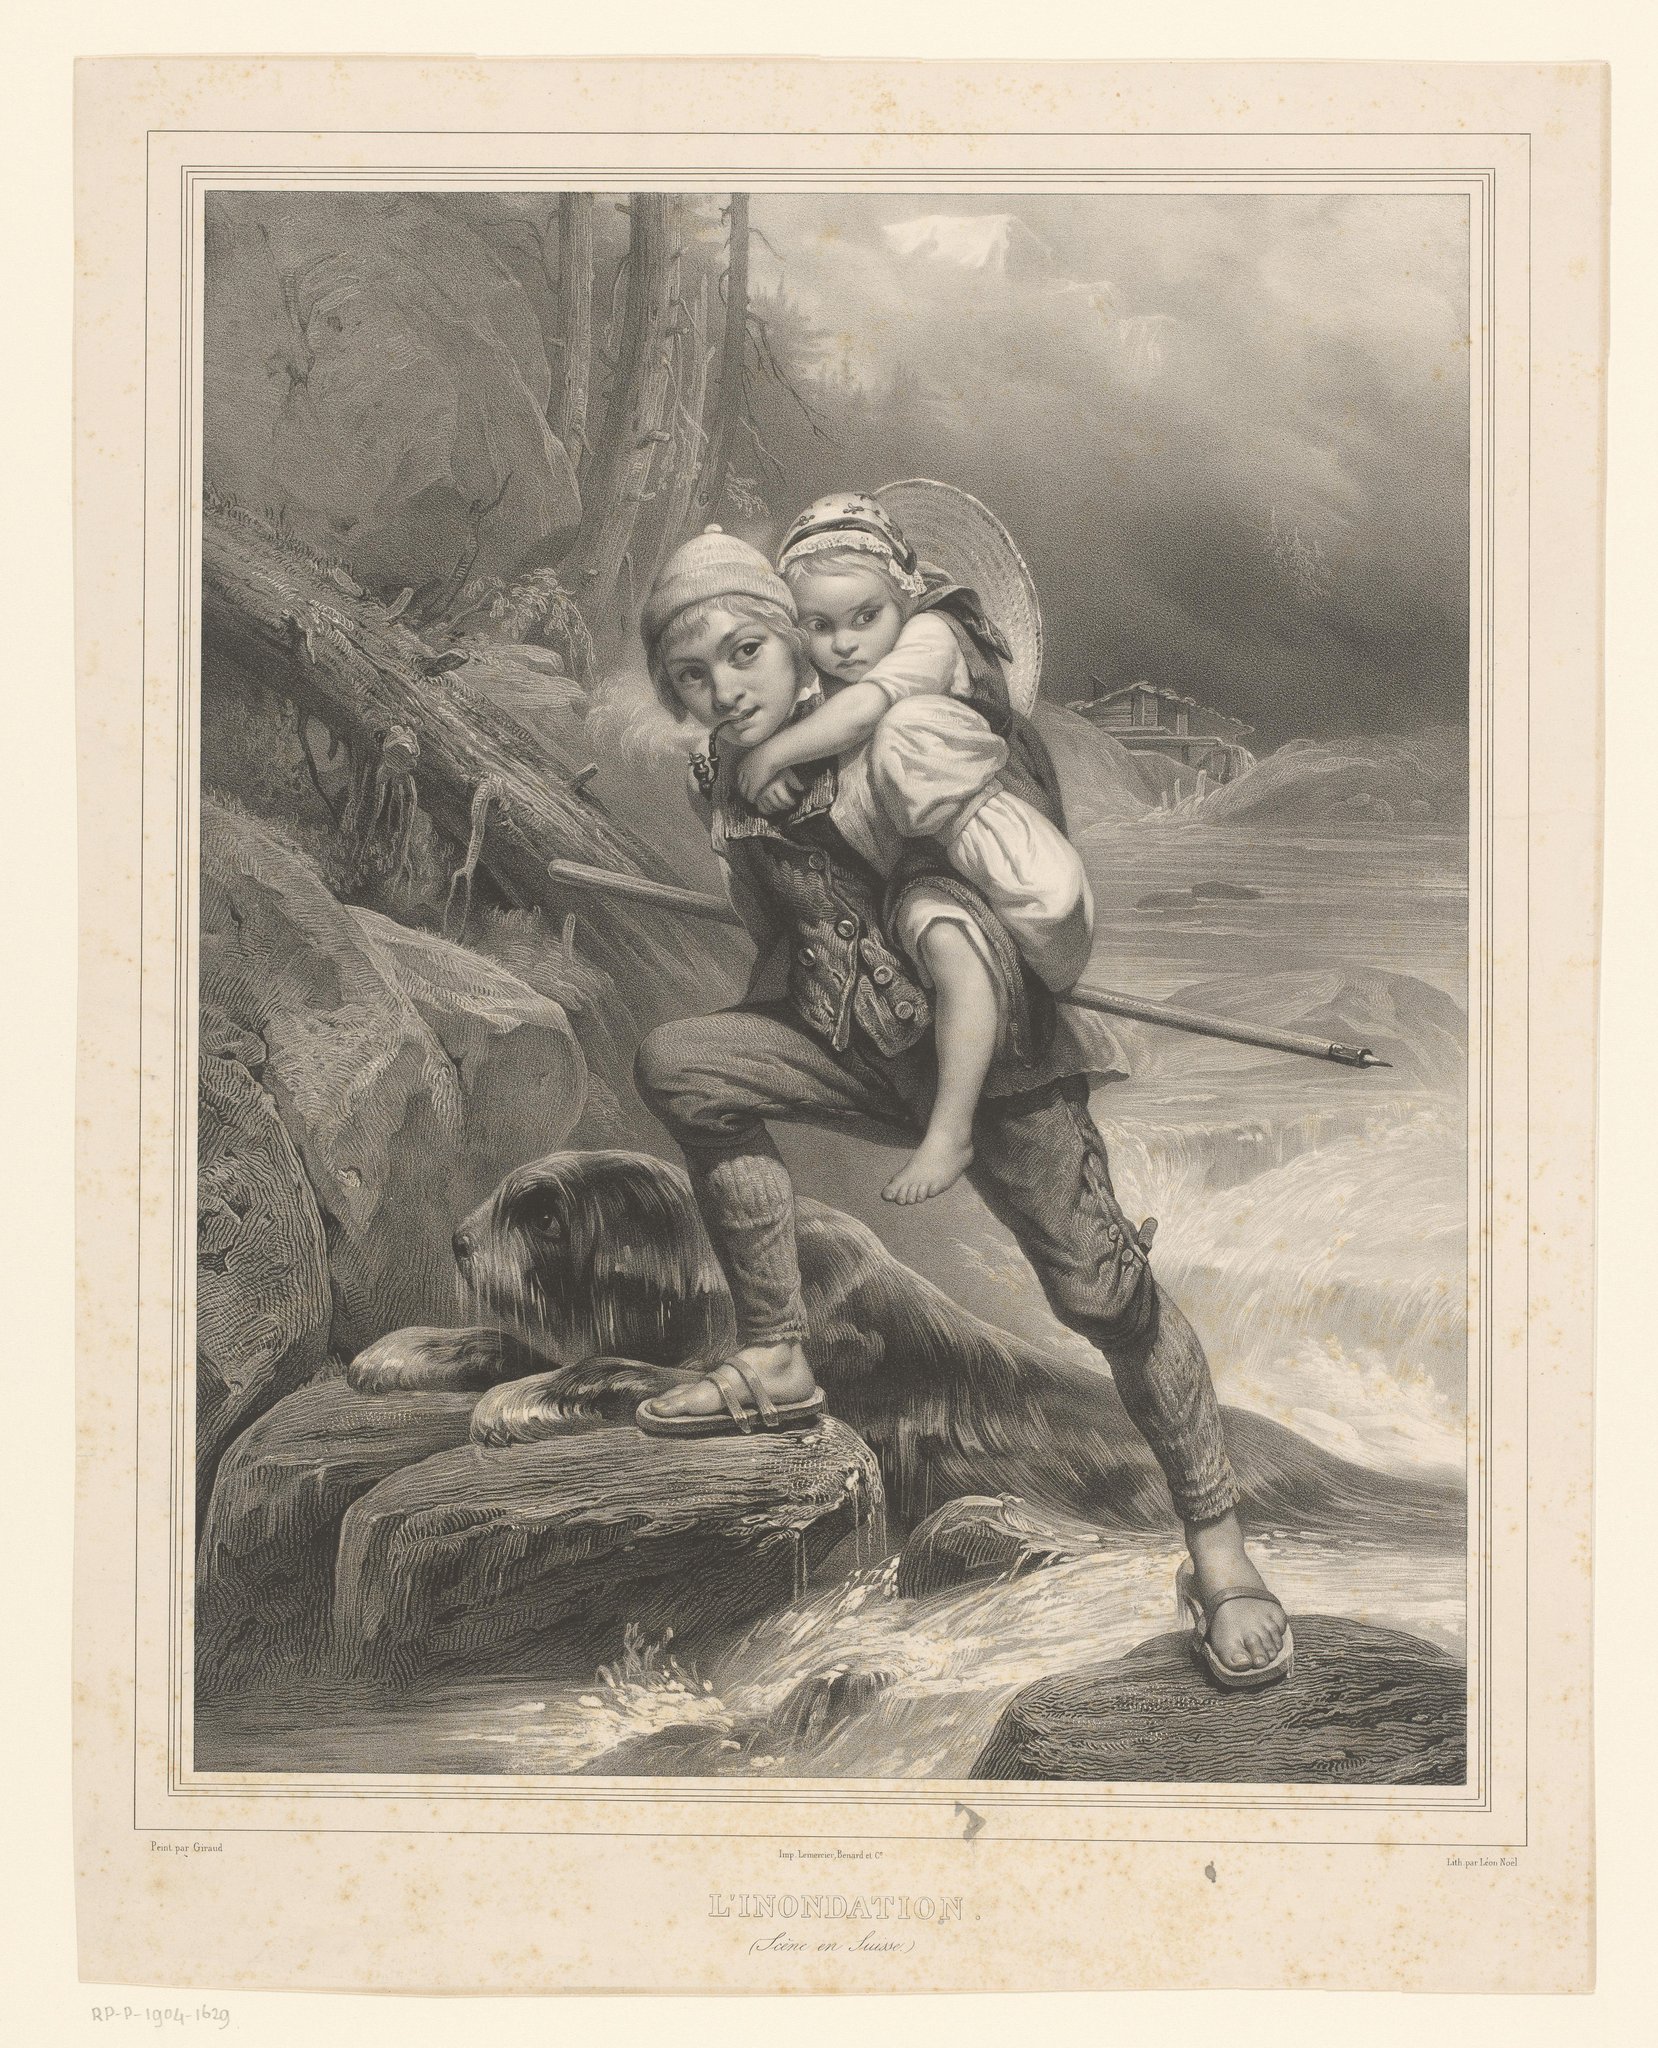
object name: print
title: L'inondation, scène en Suisse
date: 1837-1843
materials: paper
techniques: lithograph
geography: paris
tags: animals, walking-stick, staff, flood, father and child(ren), man and child(ren) (family group), switzerland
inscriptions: collector's mark: Lugt 2228, check stamp: Lugt 4802